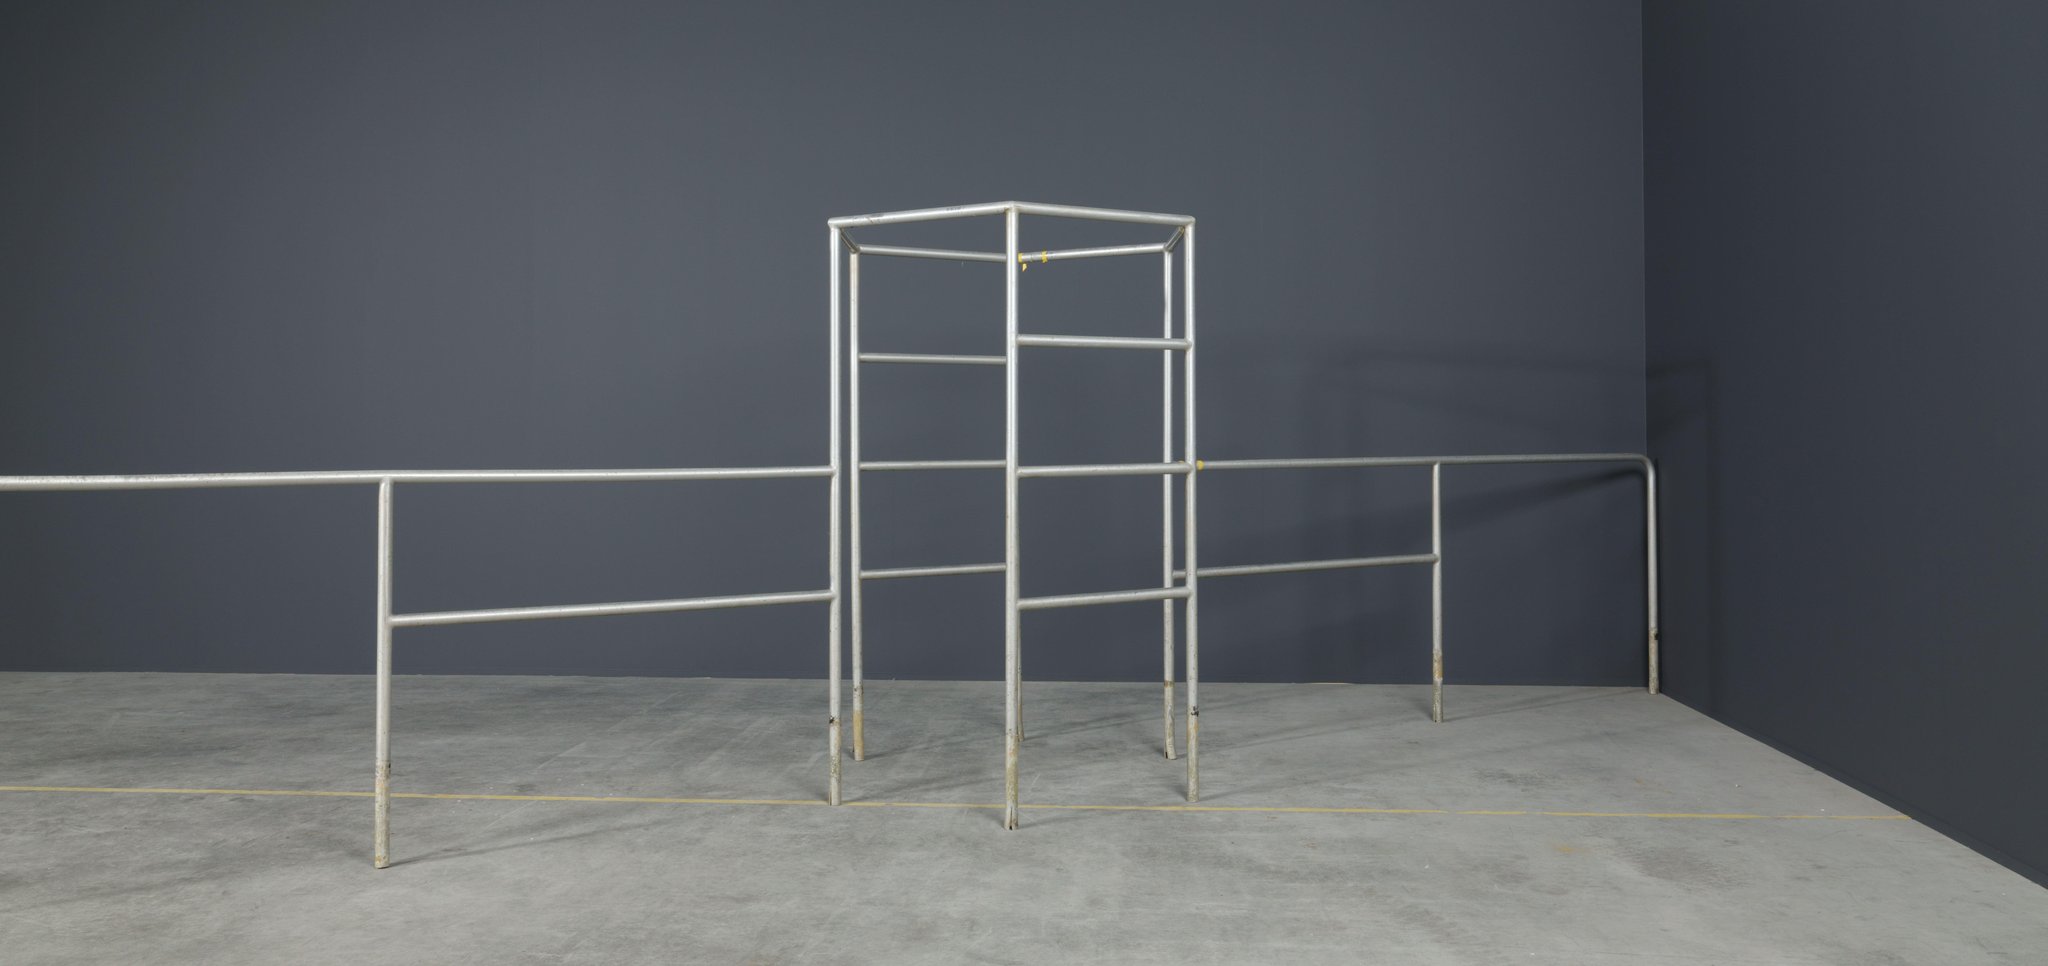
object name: speeltoestel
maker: aldo van eyck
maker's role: architect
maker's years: 1918-1999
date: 1962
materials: aluminum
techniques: welding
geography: kinderdijk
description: Aluminium buis, onderdeel van een speeltoestel.